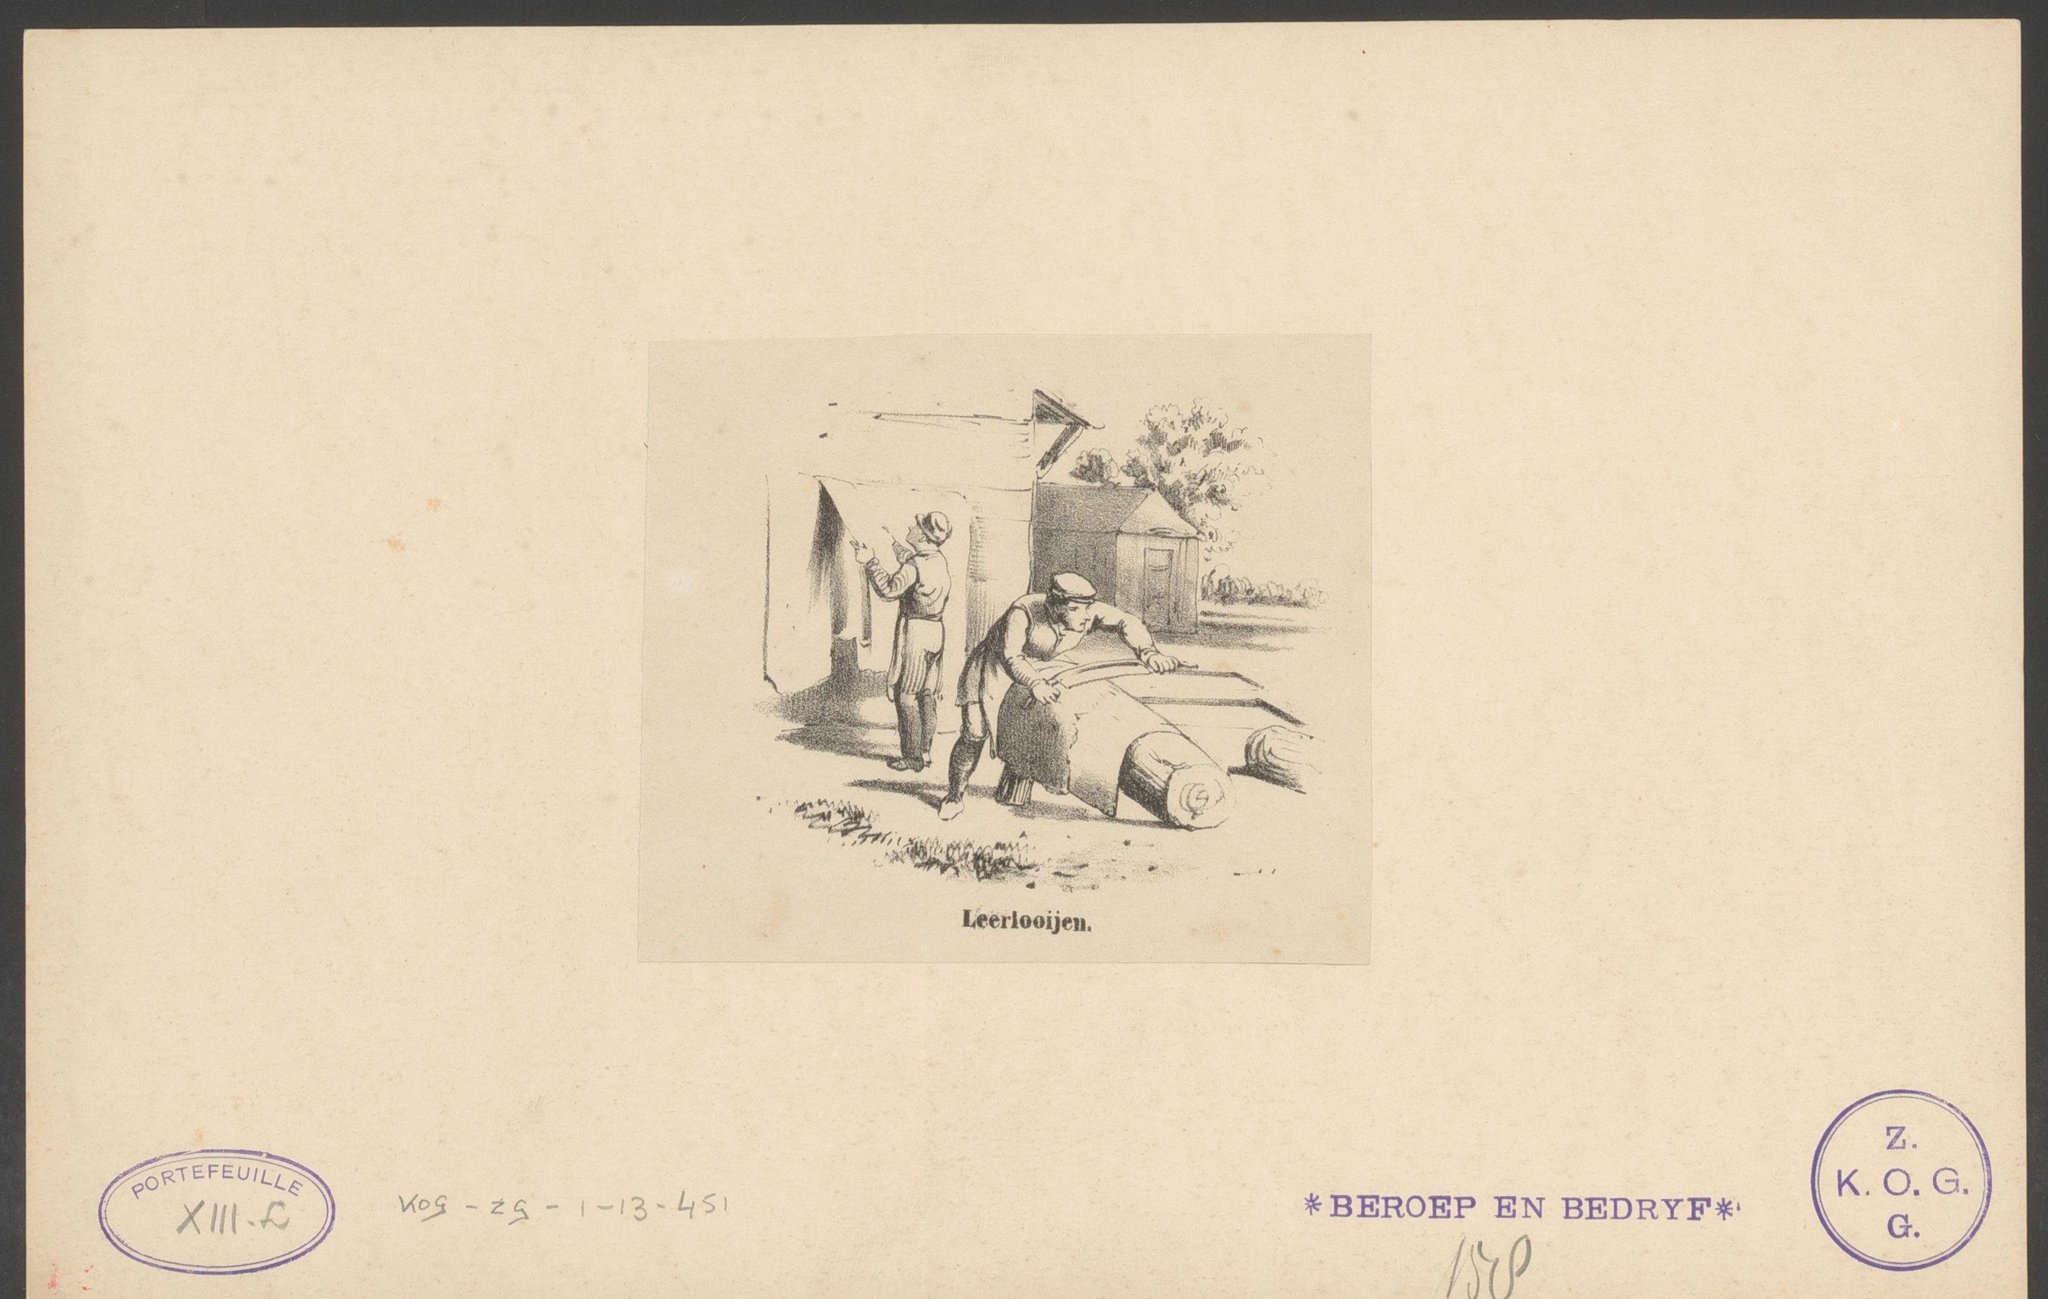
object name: print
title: Leerlooijen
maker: Anonymous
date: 1800-1899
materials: paper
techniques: lithograph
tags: tanner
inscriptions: stamp, stamp, collector's mark: Lugt 1641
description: Onderwerpsrubrieken binnen de Atlas Zeden en Gewoonten: Handel, Nijverheid en verkeer, Beroep en bedrijf, Mannelijk, Bewerkers van het leder.